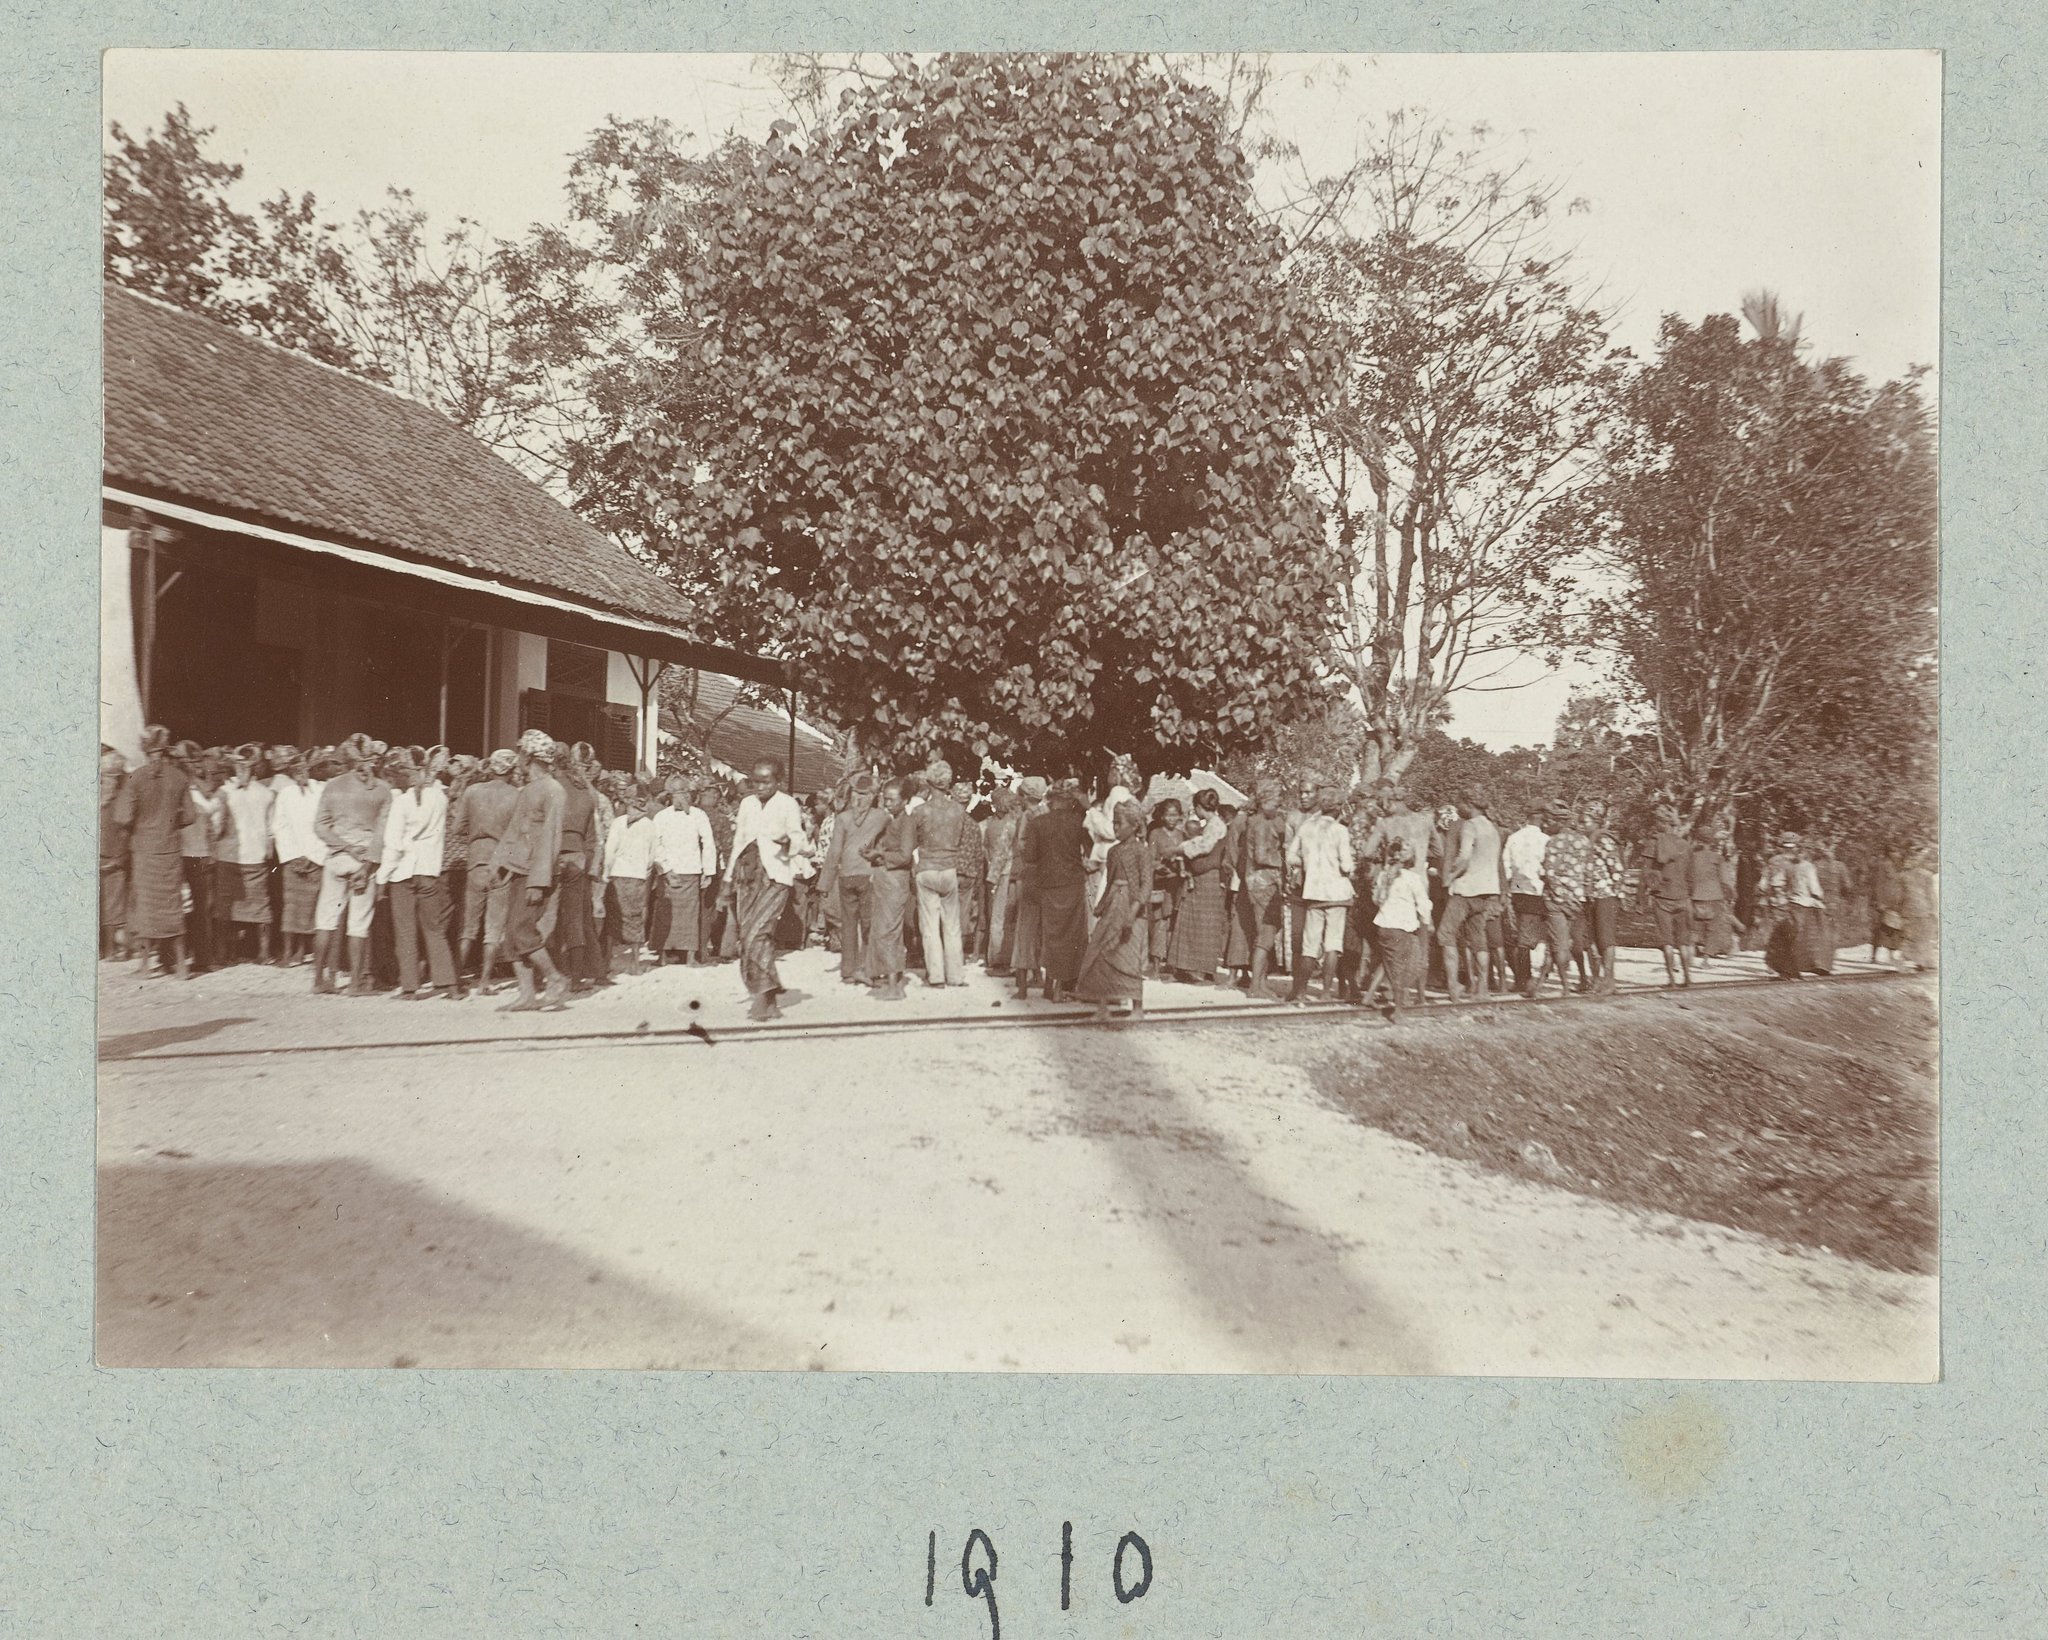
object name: photograph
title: Kaliangel Madoera, 2 Aug. 1910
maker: frits freerks fontein fz.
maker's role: fotograaf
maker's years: 1882-1928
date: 1903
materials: cardboard, paper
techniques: gelatin silver print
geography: netherlands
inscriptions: caption: ‘Kaliangel Madoera, 2 Aug. 1910’